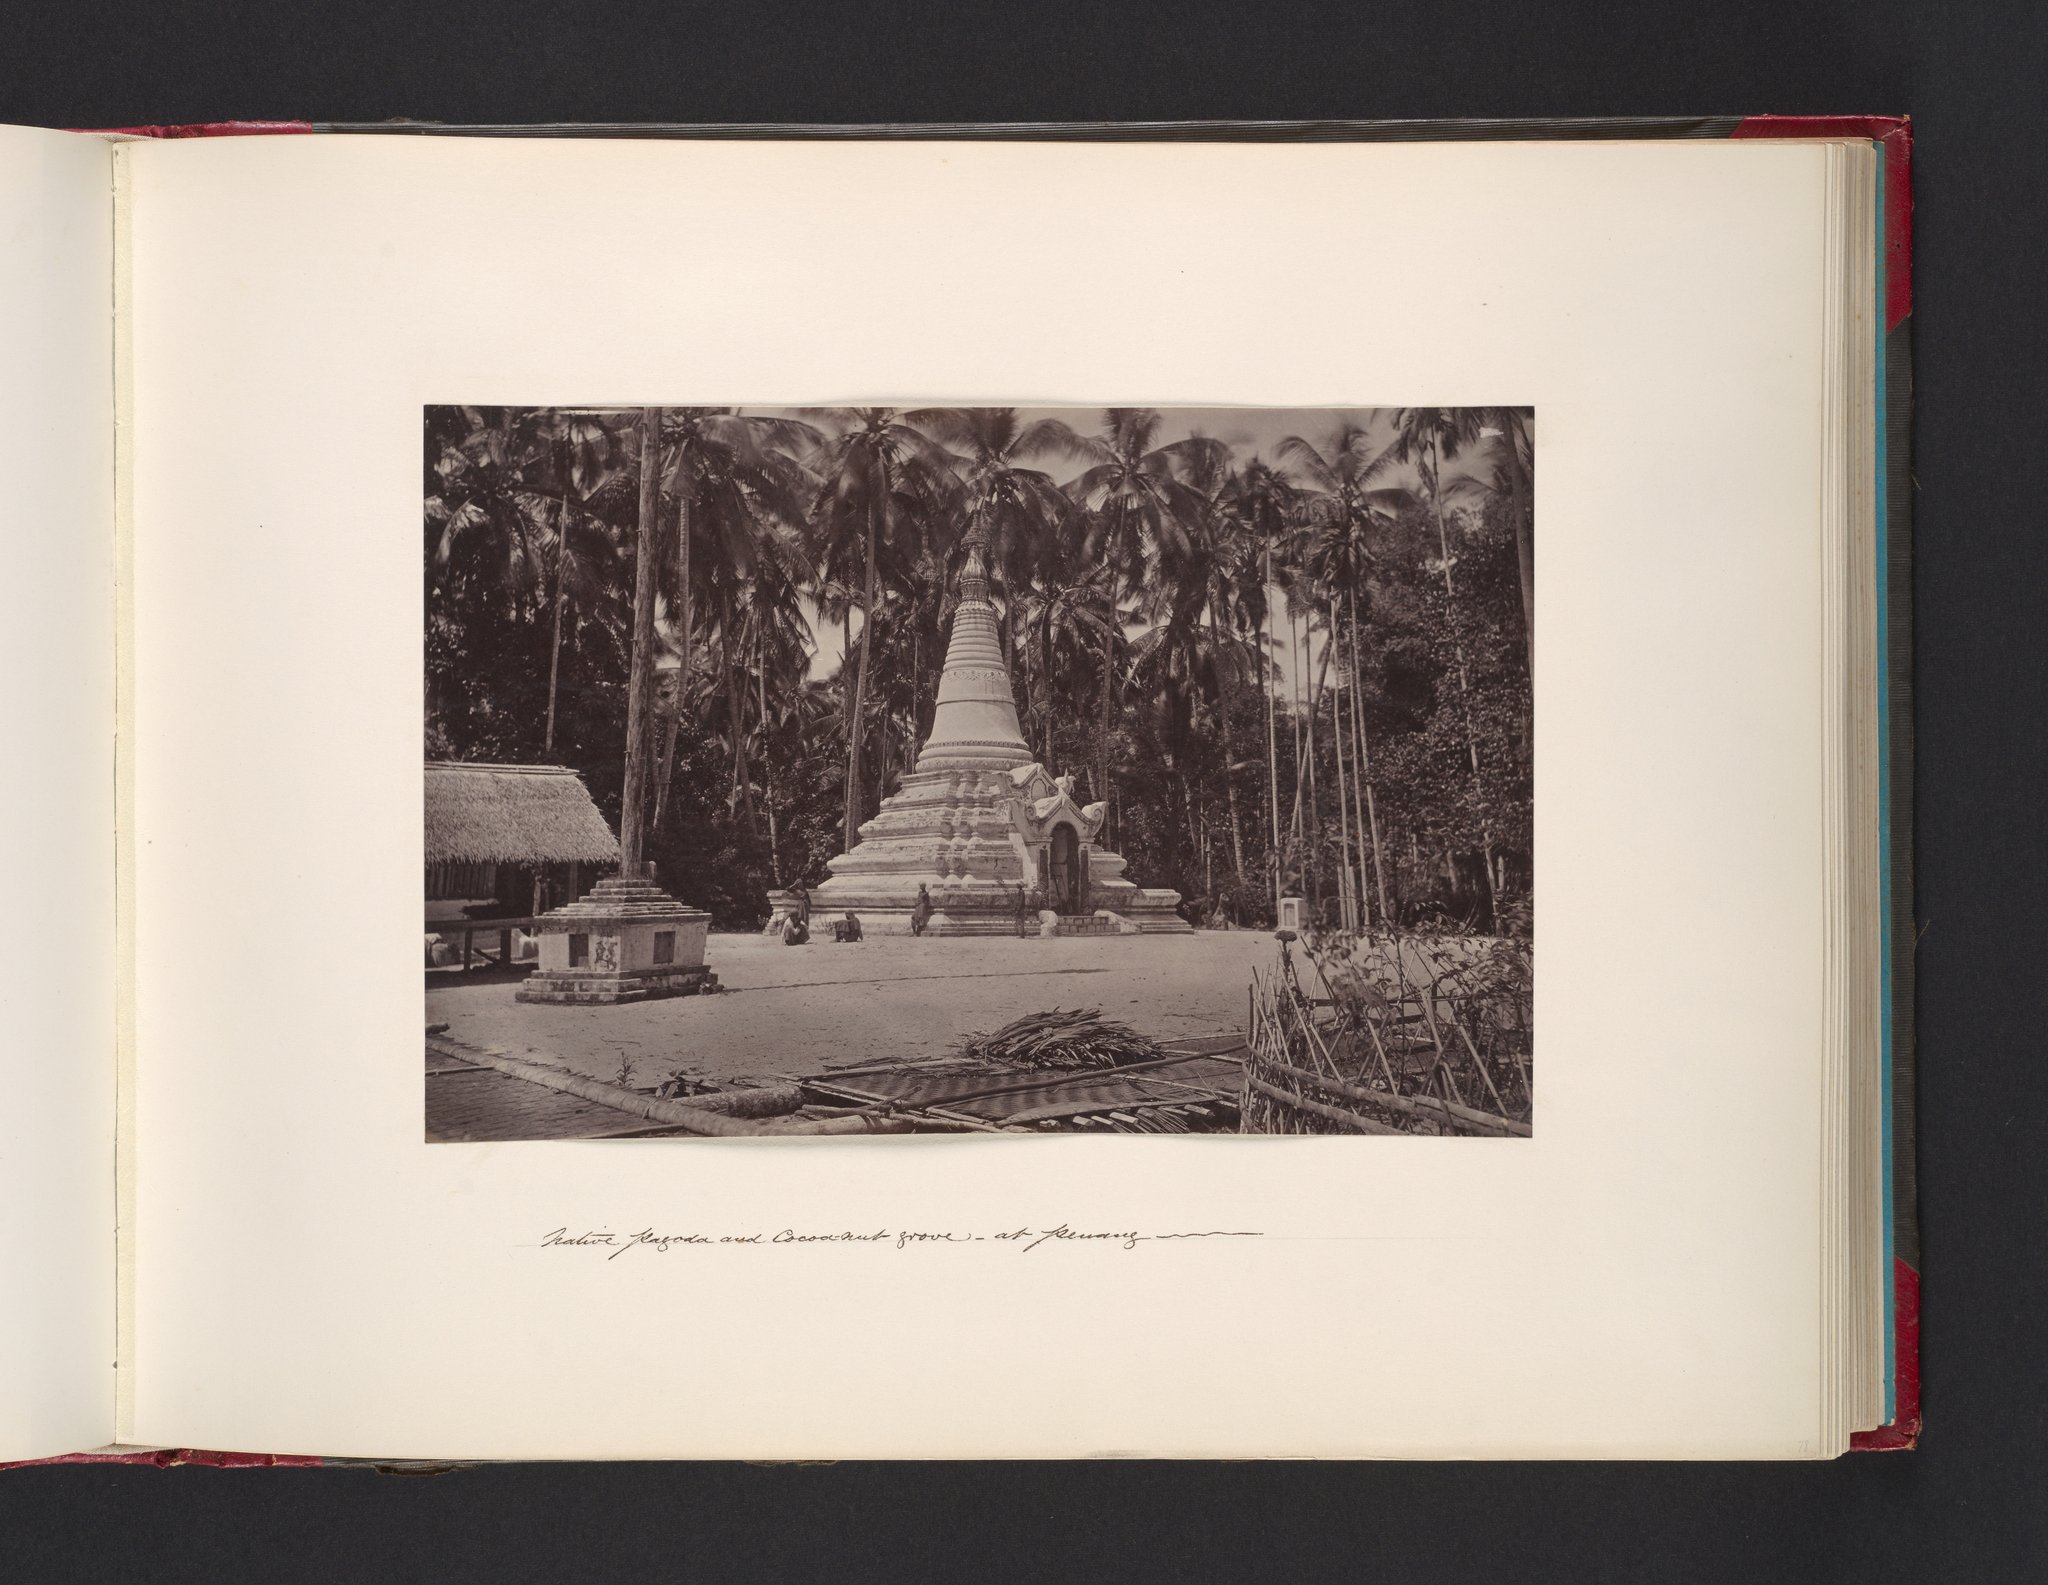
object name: photograph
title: Native Pagoda and Coconut Grove at Penang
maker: john thomson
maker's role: artist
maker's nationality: british, scottish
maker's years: 1837-1921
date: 1865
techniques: albumen silver print, glass negative